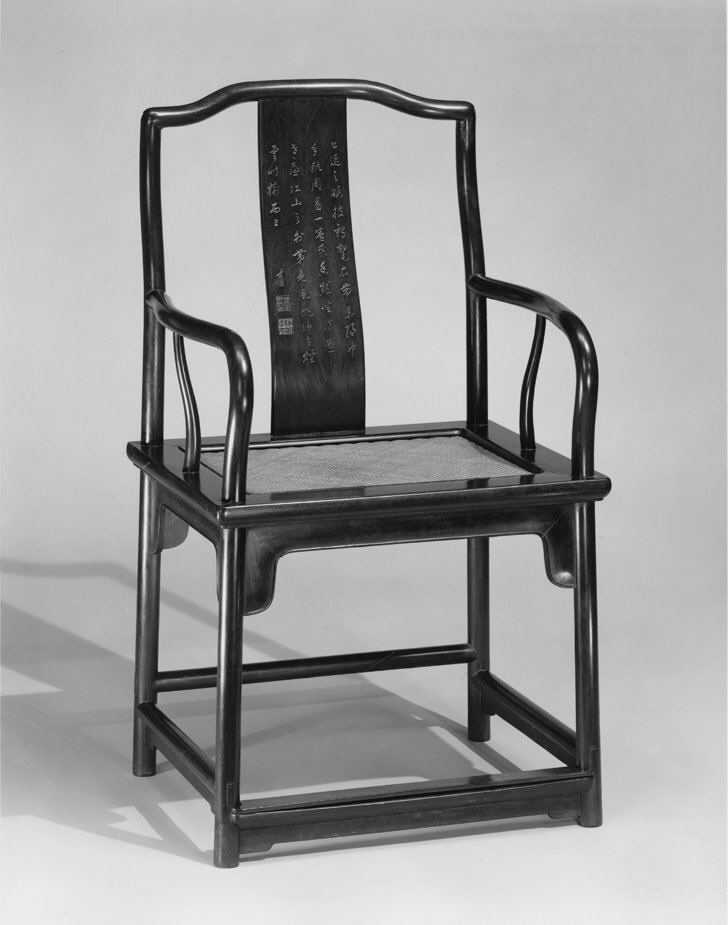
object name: armchair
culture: chinese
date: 1601-1700